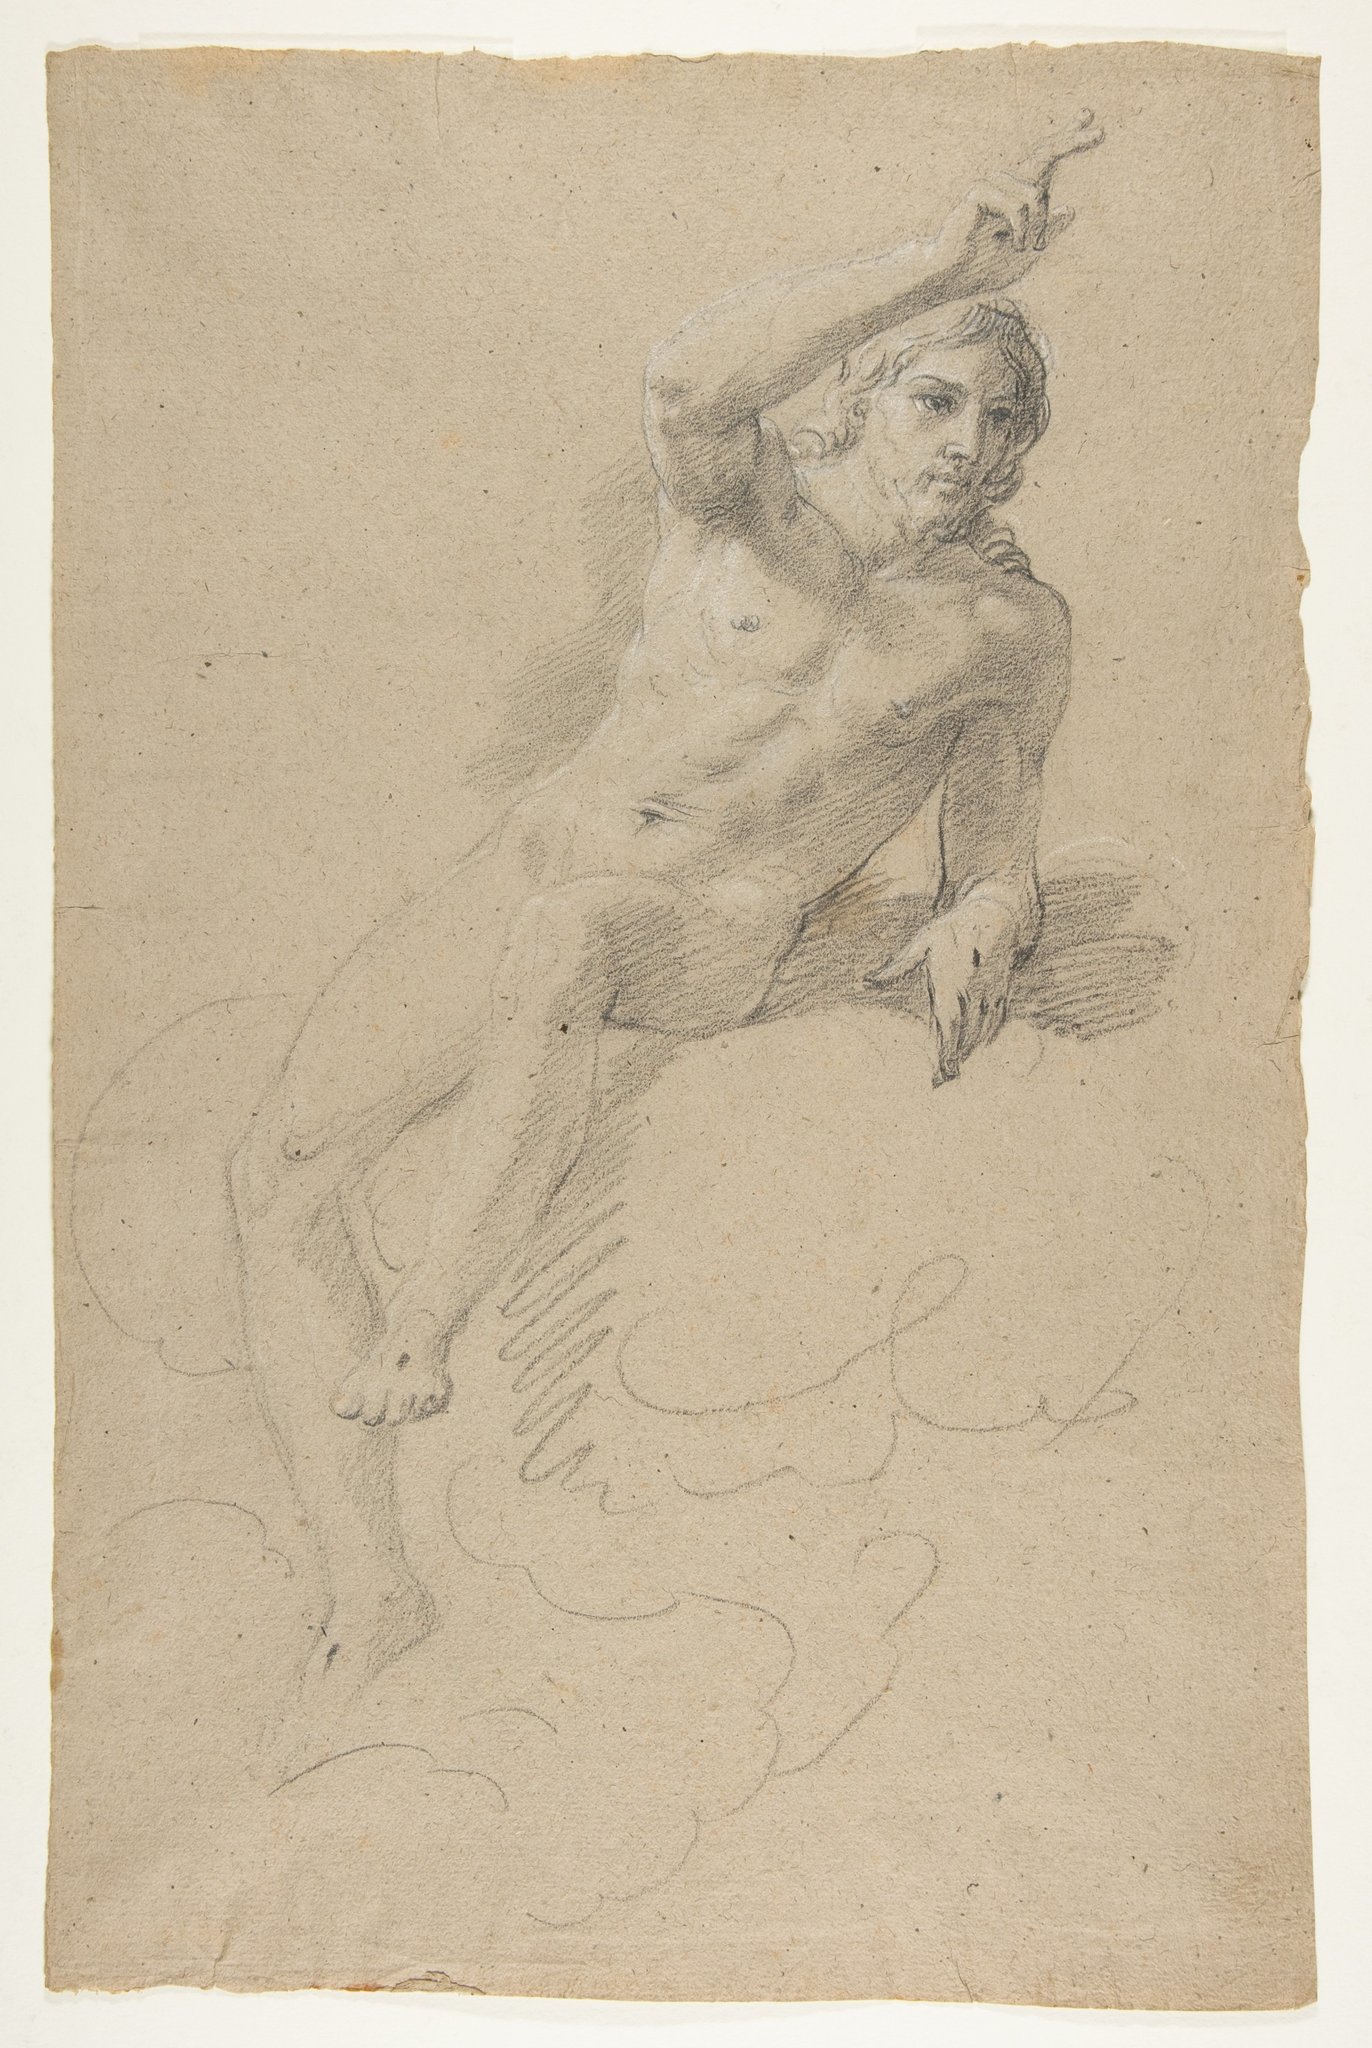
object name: drawing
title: Christ Blessing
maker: giacomo zoboli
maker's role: artist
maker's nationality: italian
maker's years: 1681-1767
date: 1681-1767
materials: chalk, paper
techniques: highlighting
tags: christ